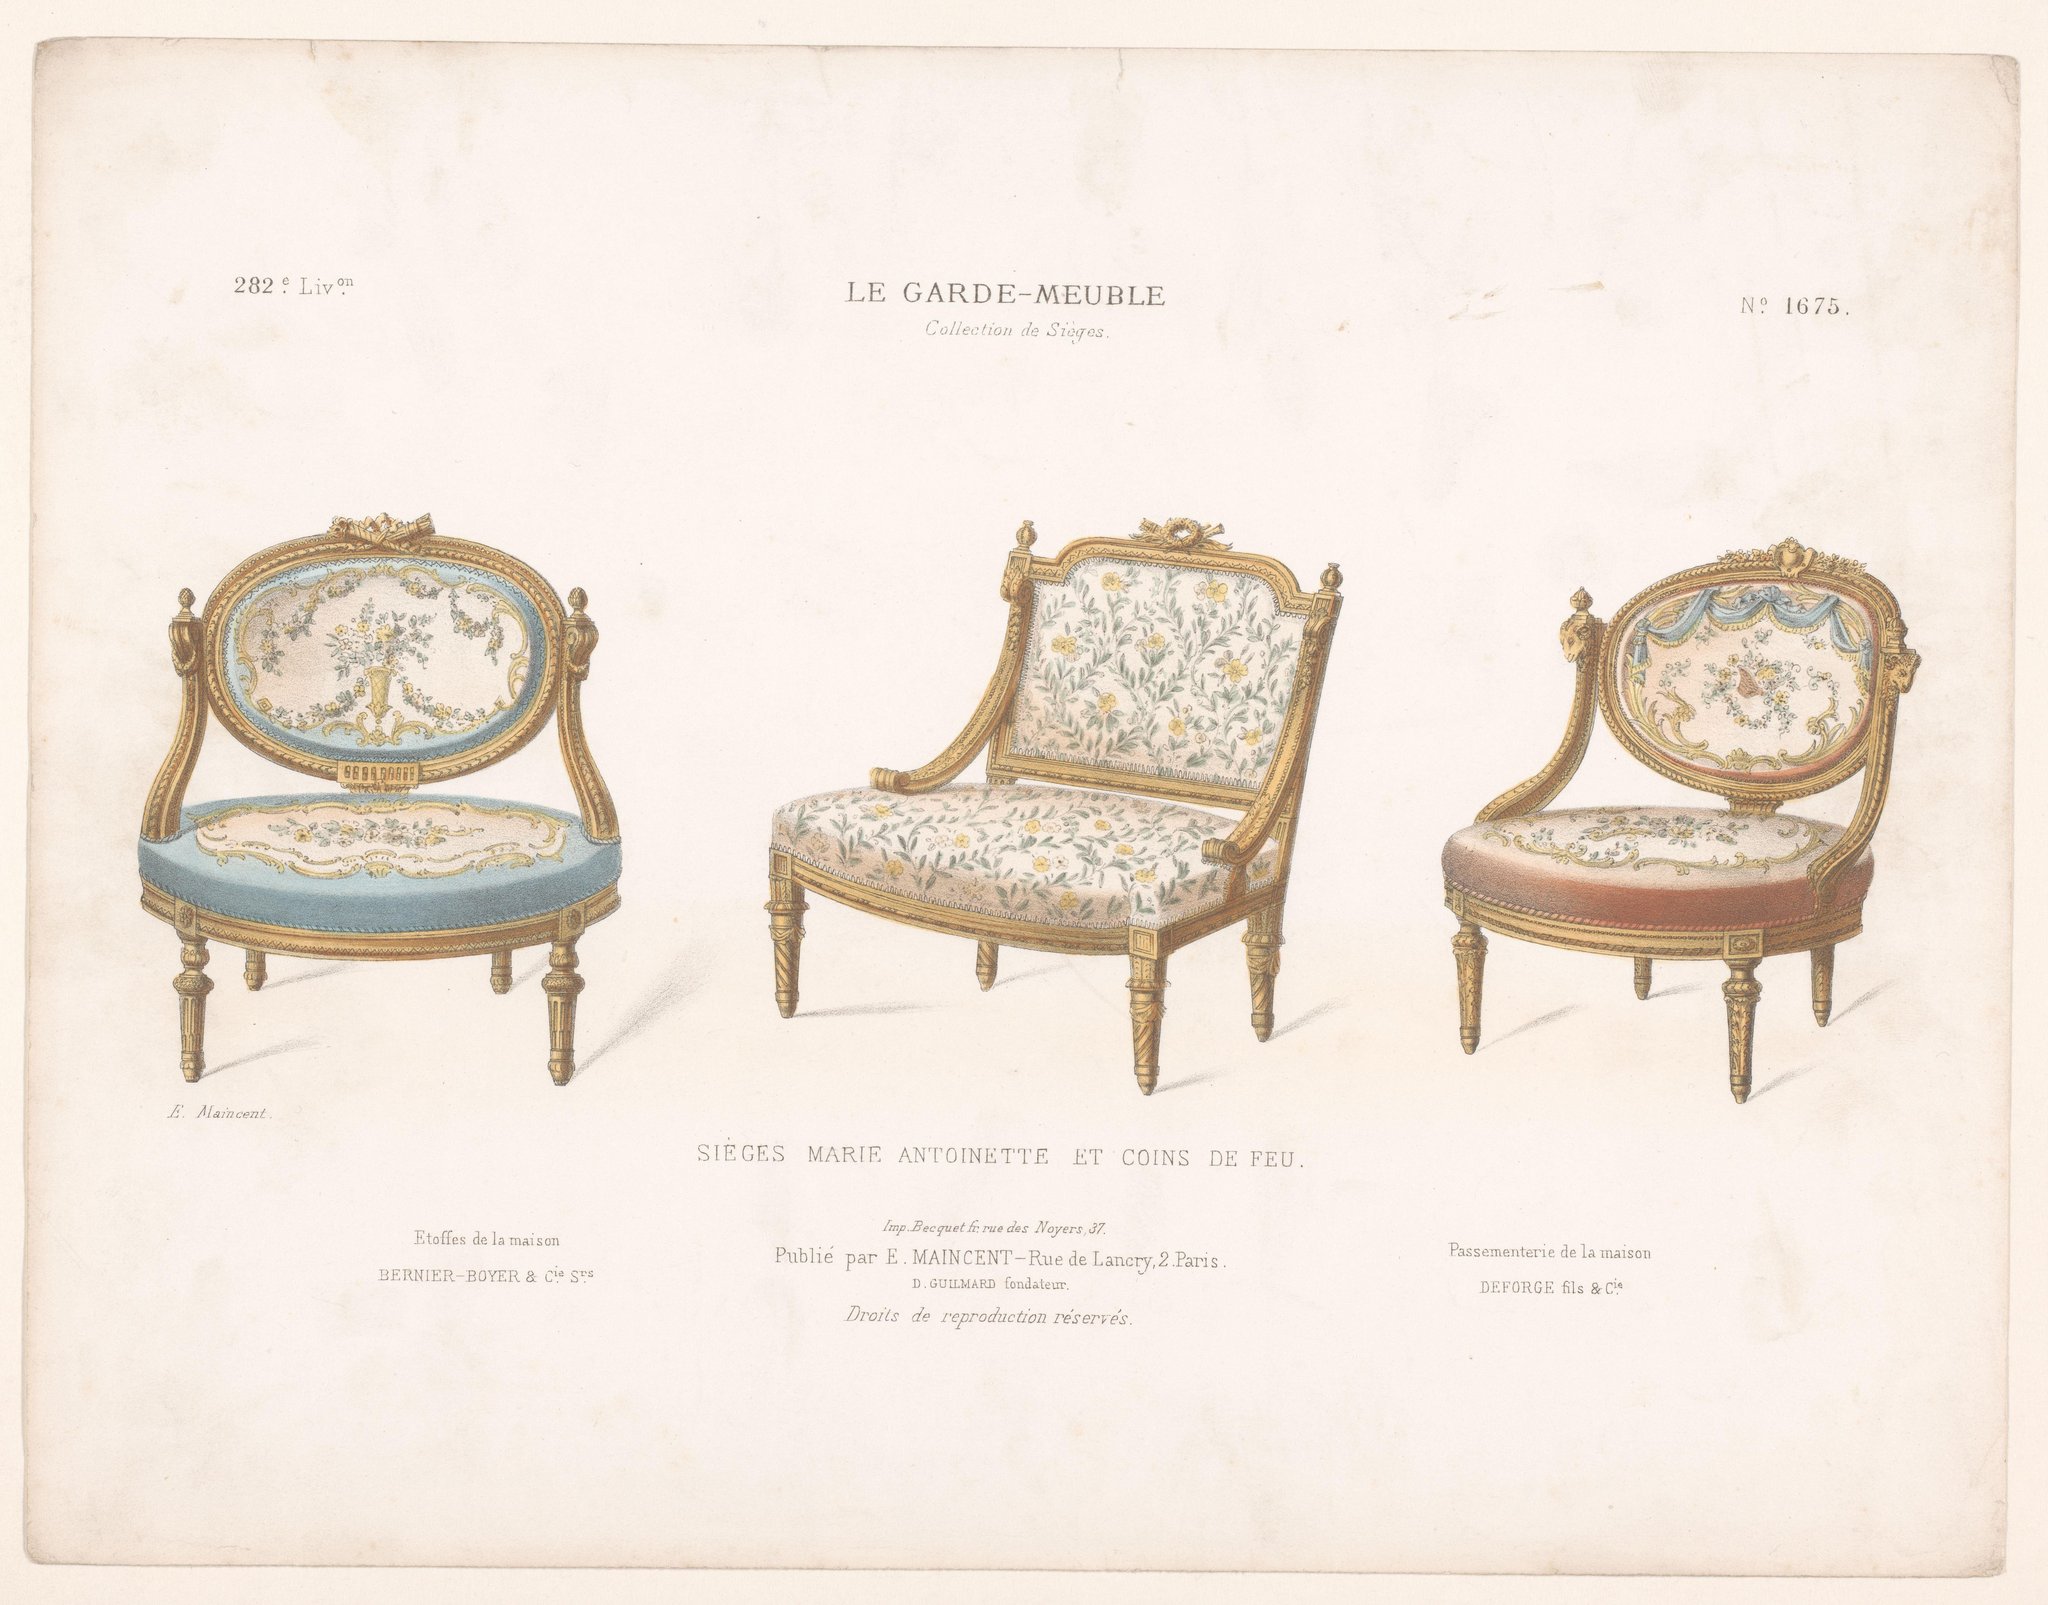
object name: print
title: Drie stoelen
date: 1885-1895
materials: paper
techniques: hand coloring, lithograph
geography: paris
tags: seating furniture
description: Ieder Livraison in de serie Le Garde-Meuble bevat negen platen: drie 'sièges' (zitmeubels), drie 'meubles' (diverse meubels zoals tafels en kasten) en drie 'tentures' (gordijnen en draperieën).